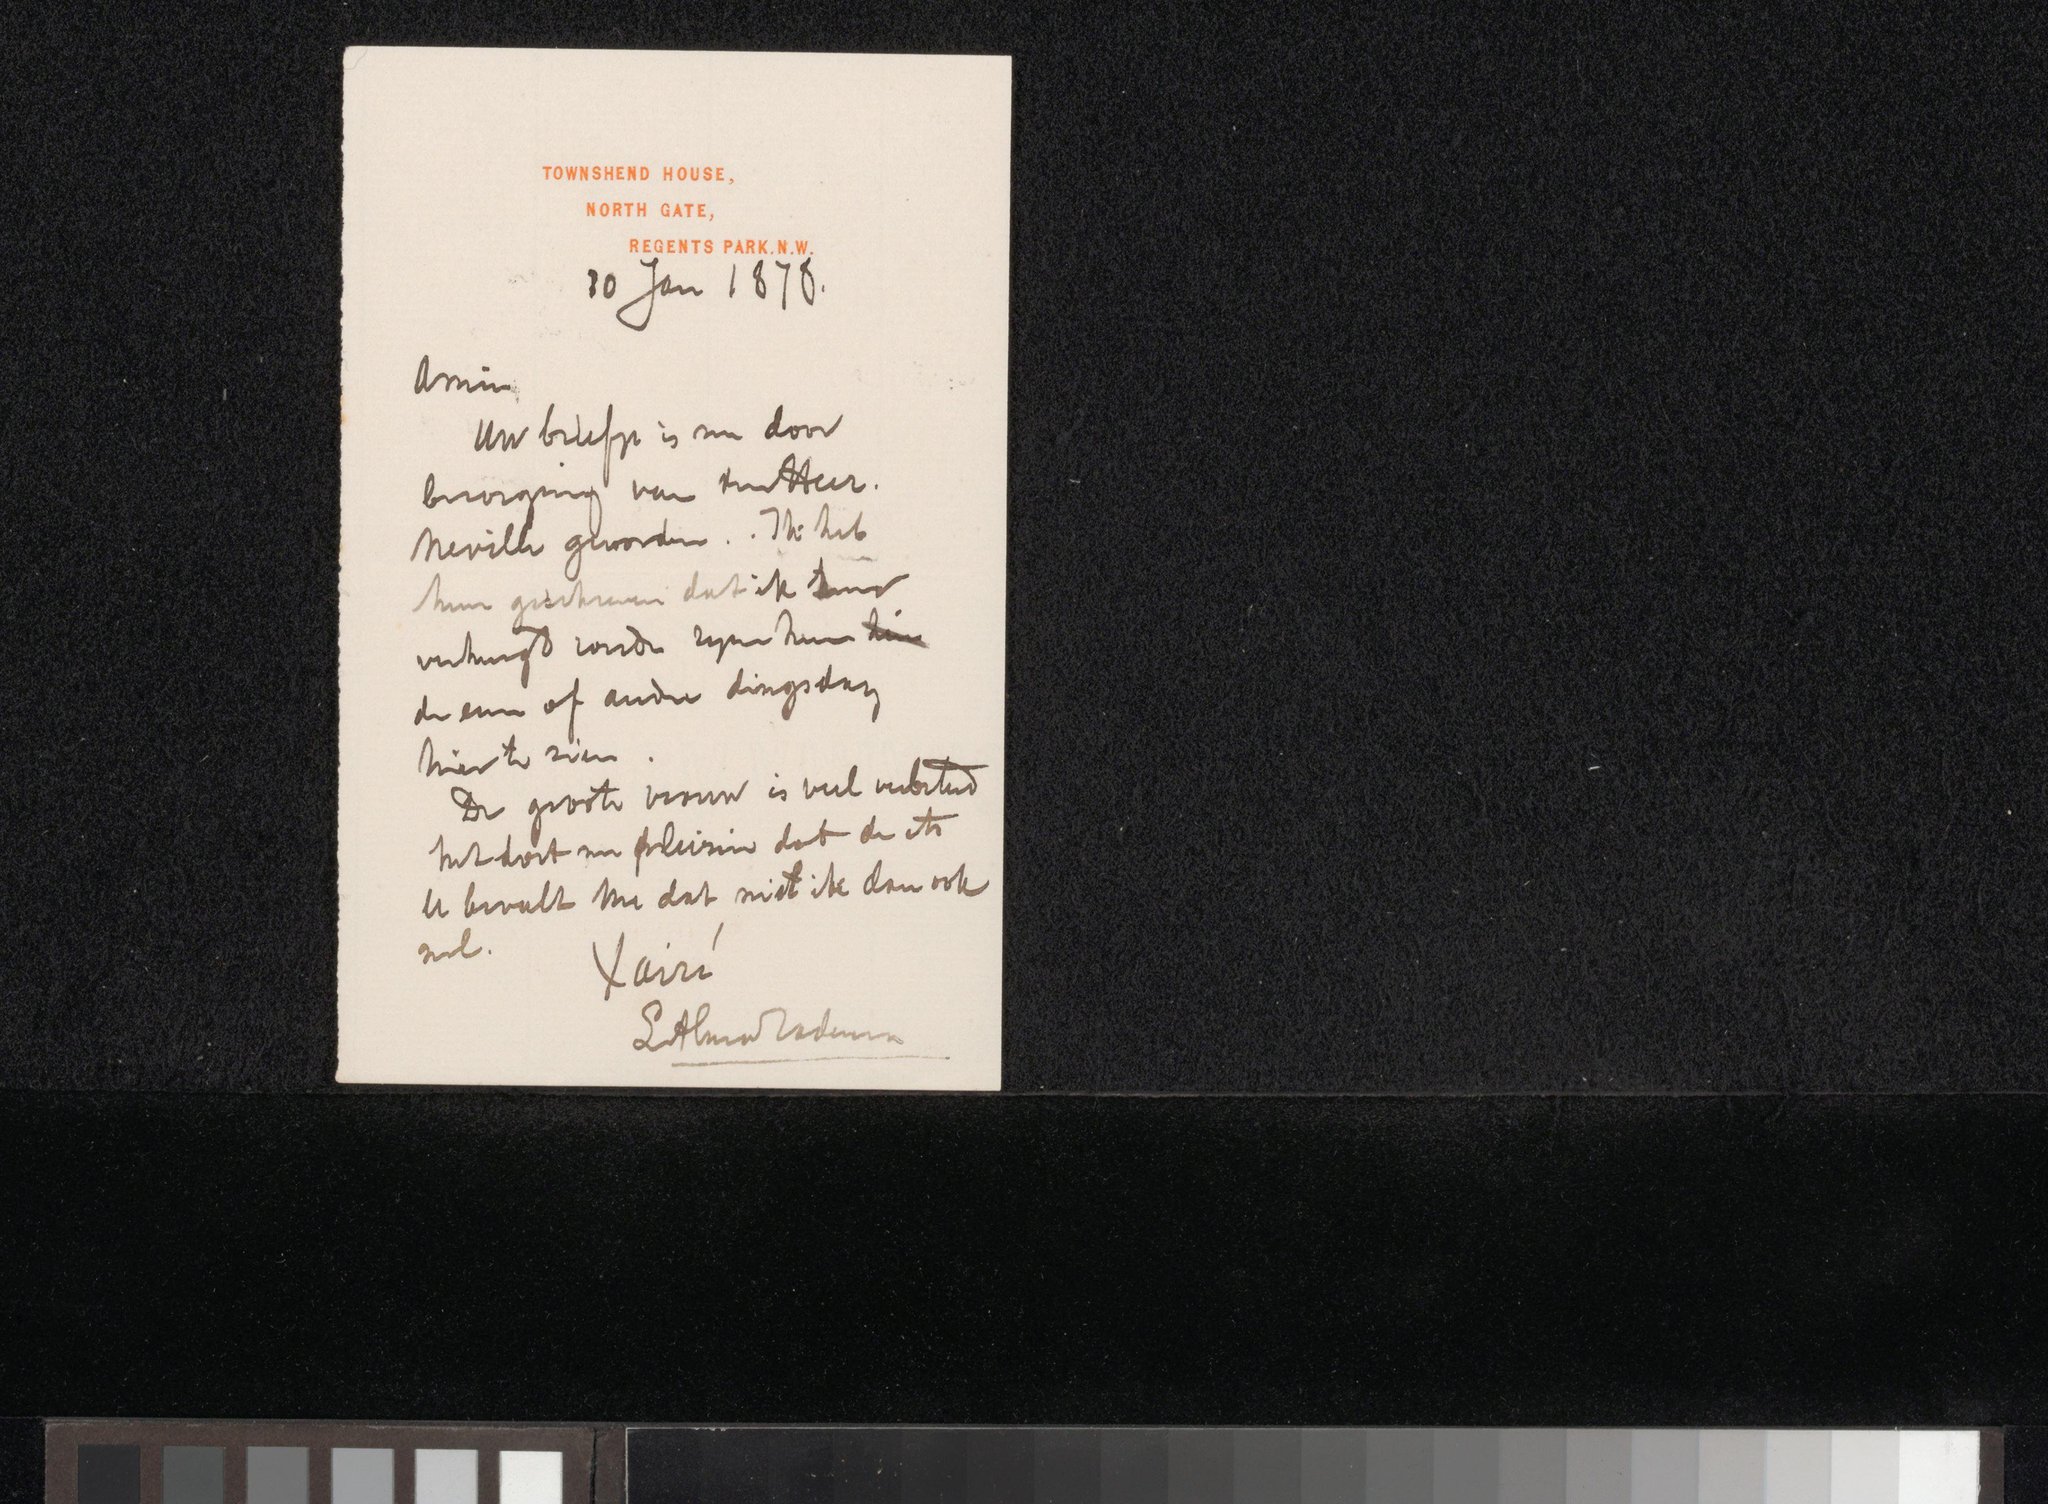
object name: letter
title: Brief aan Carel Vosmaer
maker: lourens alma tadema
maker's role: draughtsman, print maker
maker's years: 1836-1912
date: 1878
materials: ink, paper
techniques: pen, printing, writing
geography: london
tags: the hague, print maker, draughtsman, carel vosmaer, the graphic arts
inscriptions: watermark